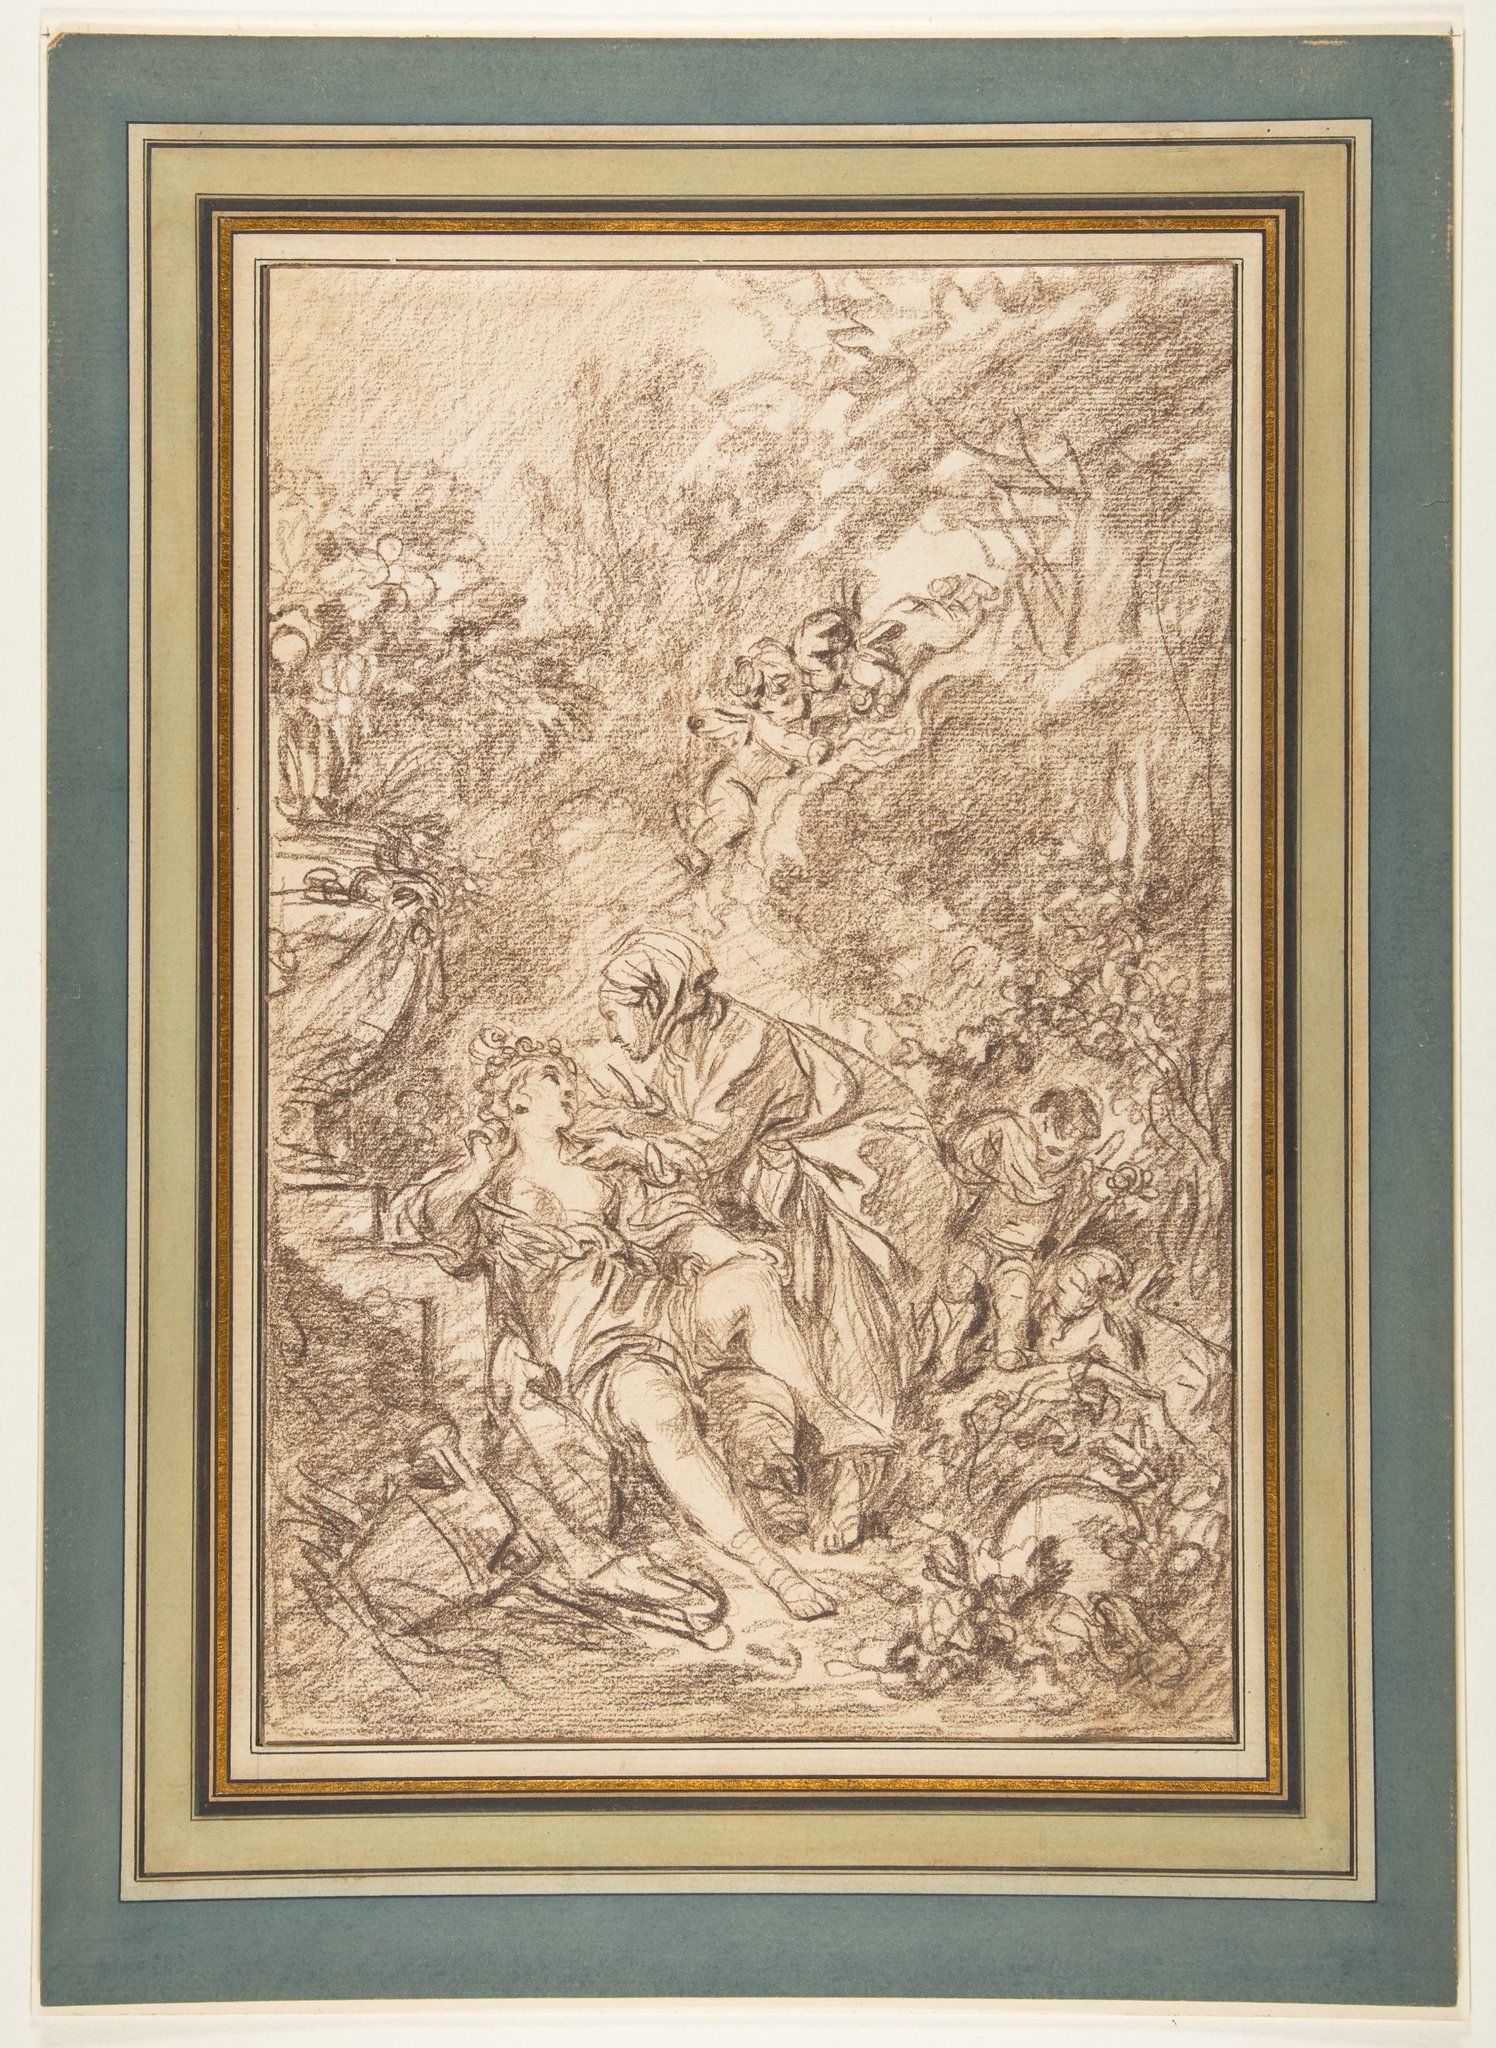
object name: drawing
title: Vertumnus and Pomona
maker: françois boucher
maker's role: artist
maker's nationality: french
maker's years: 1703-1770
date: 1700-1770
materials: chalk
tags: putti,vertumnus,pomona